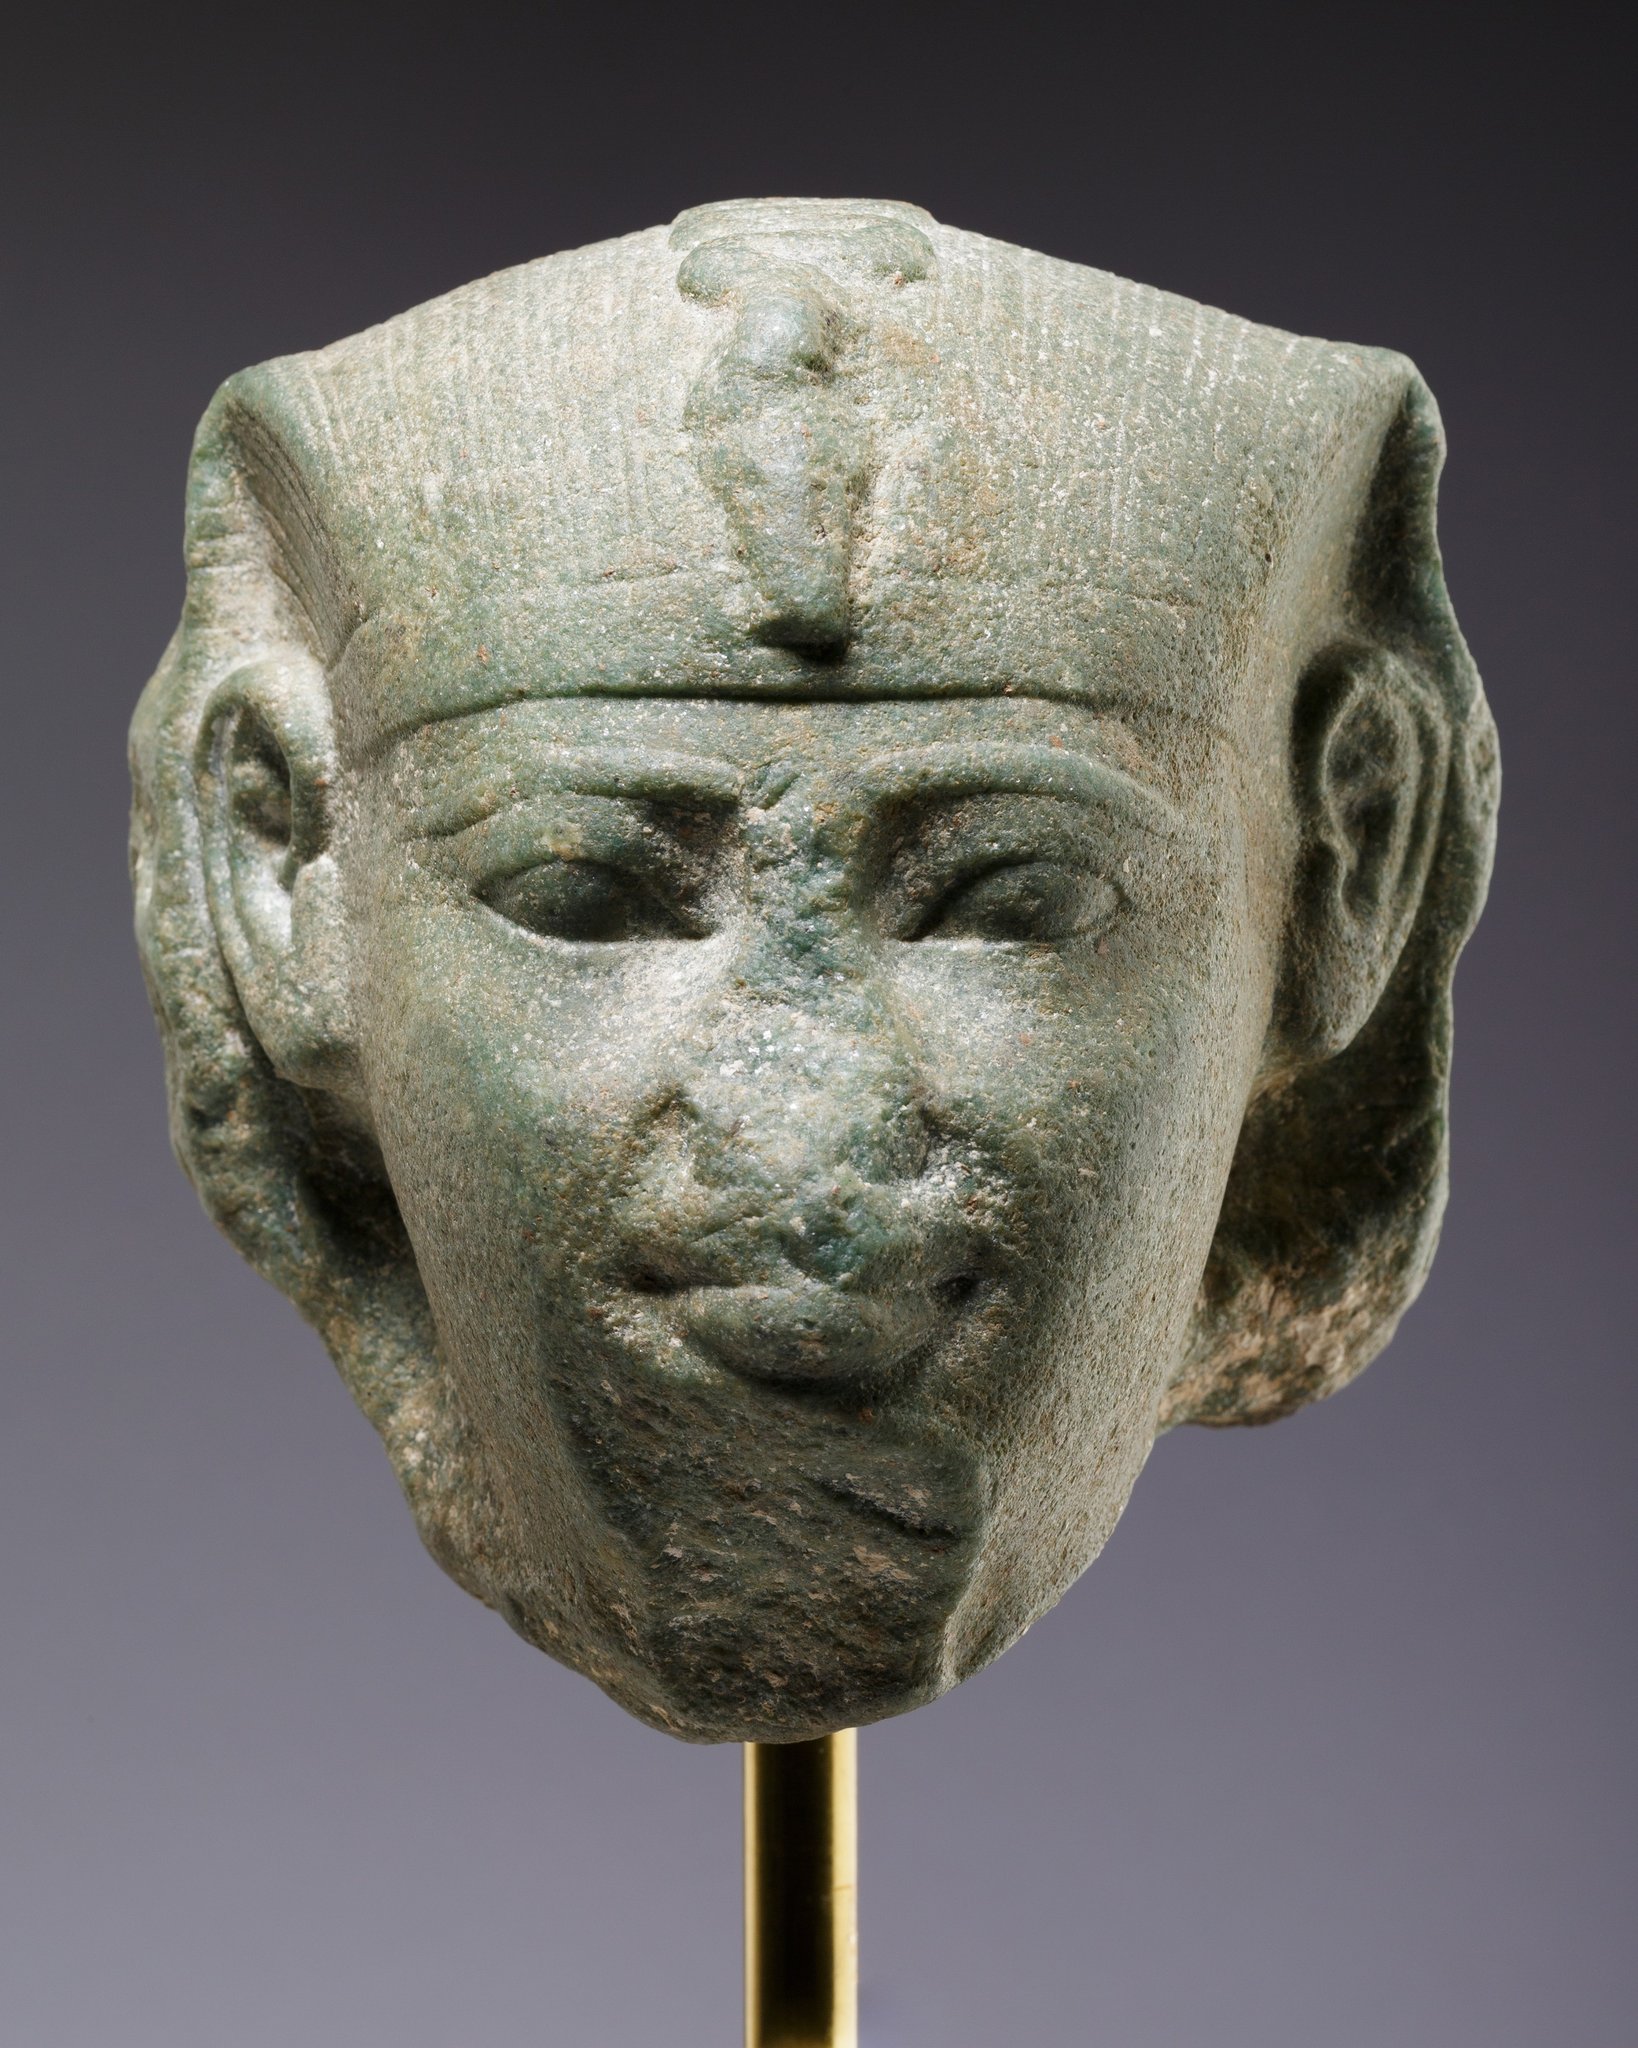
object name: head, sphinx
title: Head of a sphinx, possibly of Amenemhat I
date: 1981-1952 BCE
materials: marble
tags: sphinx,mk-kings